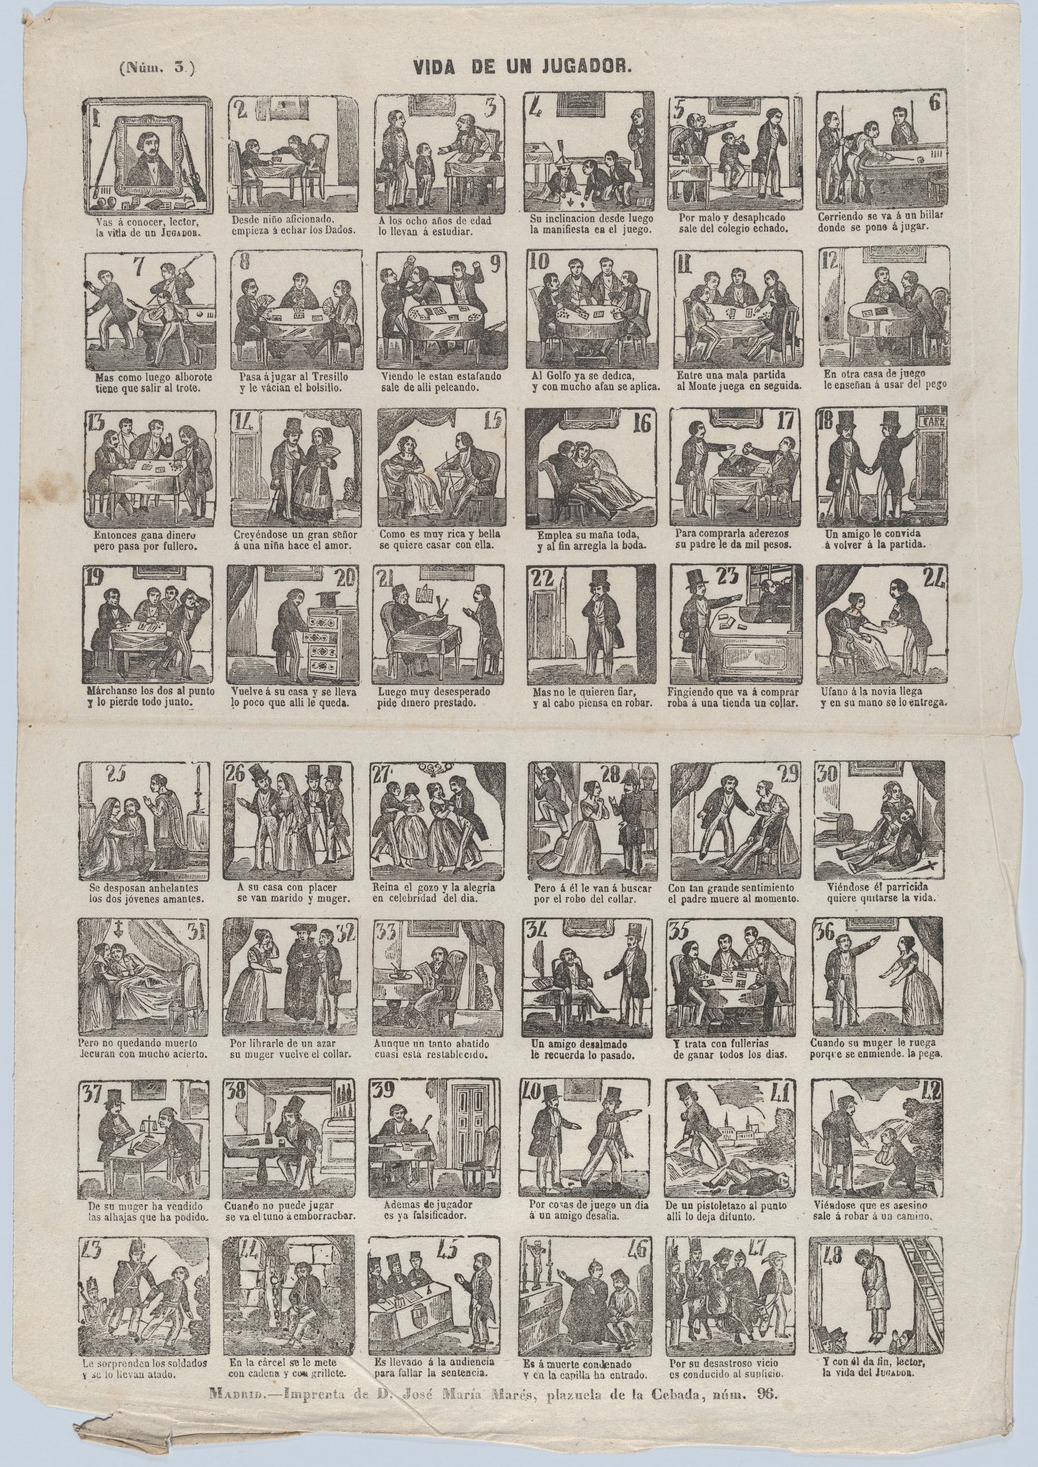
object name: print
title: Broadside with 48 scenes depicting the life of a charlatan (player)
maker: josé maría marés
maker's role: publisher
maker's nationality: spanish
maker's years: 1850-1870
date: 1860-1870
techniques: engraving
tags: men,women